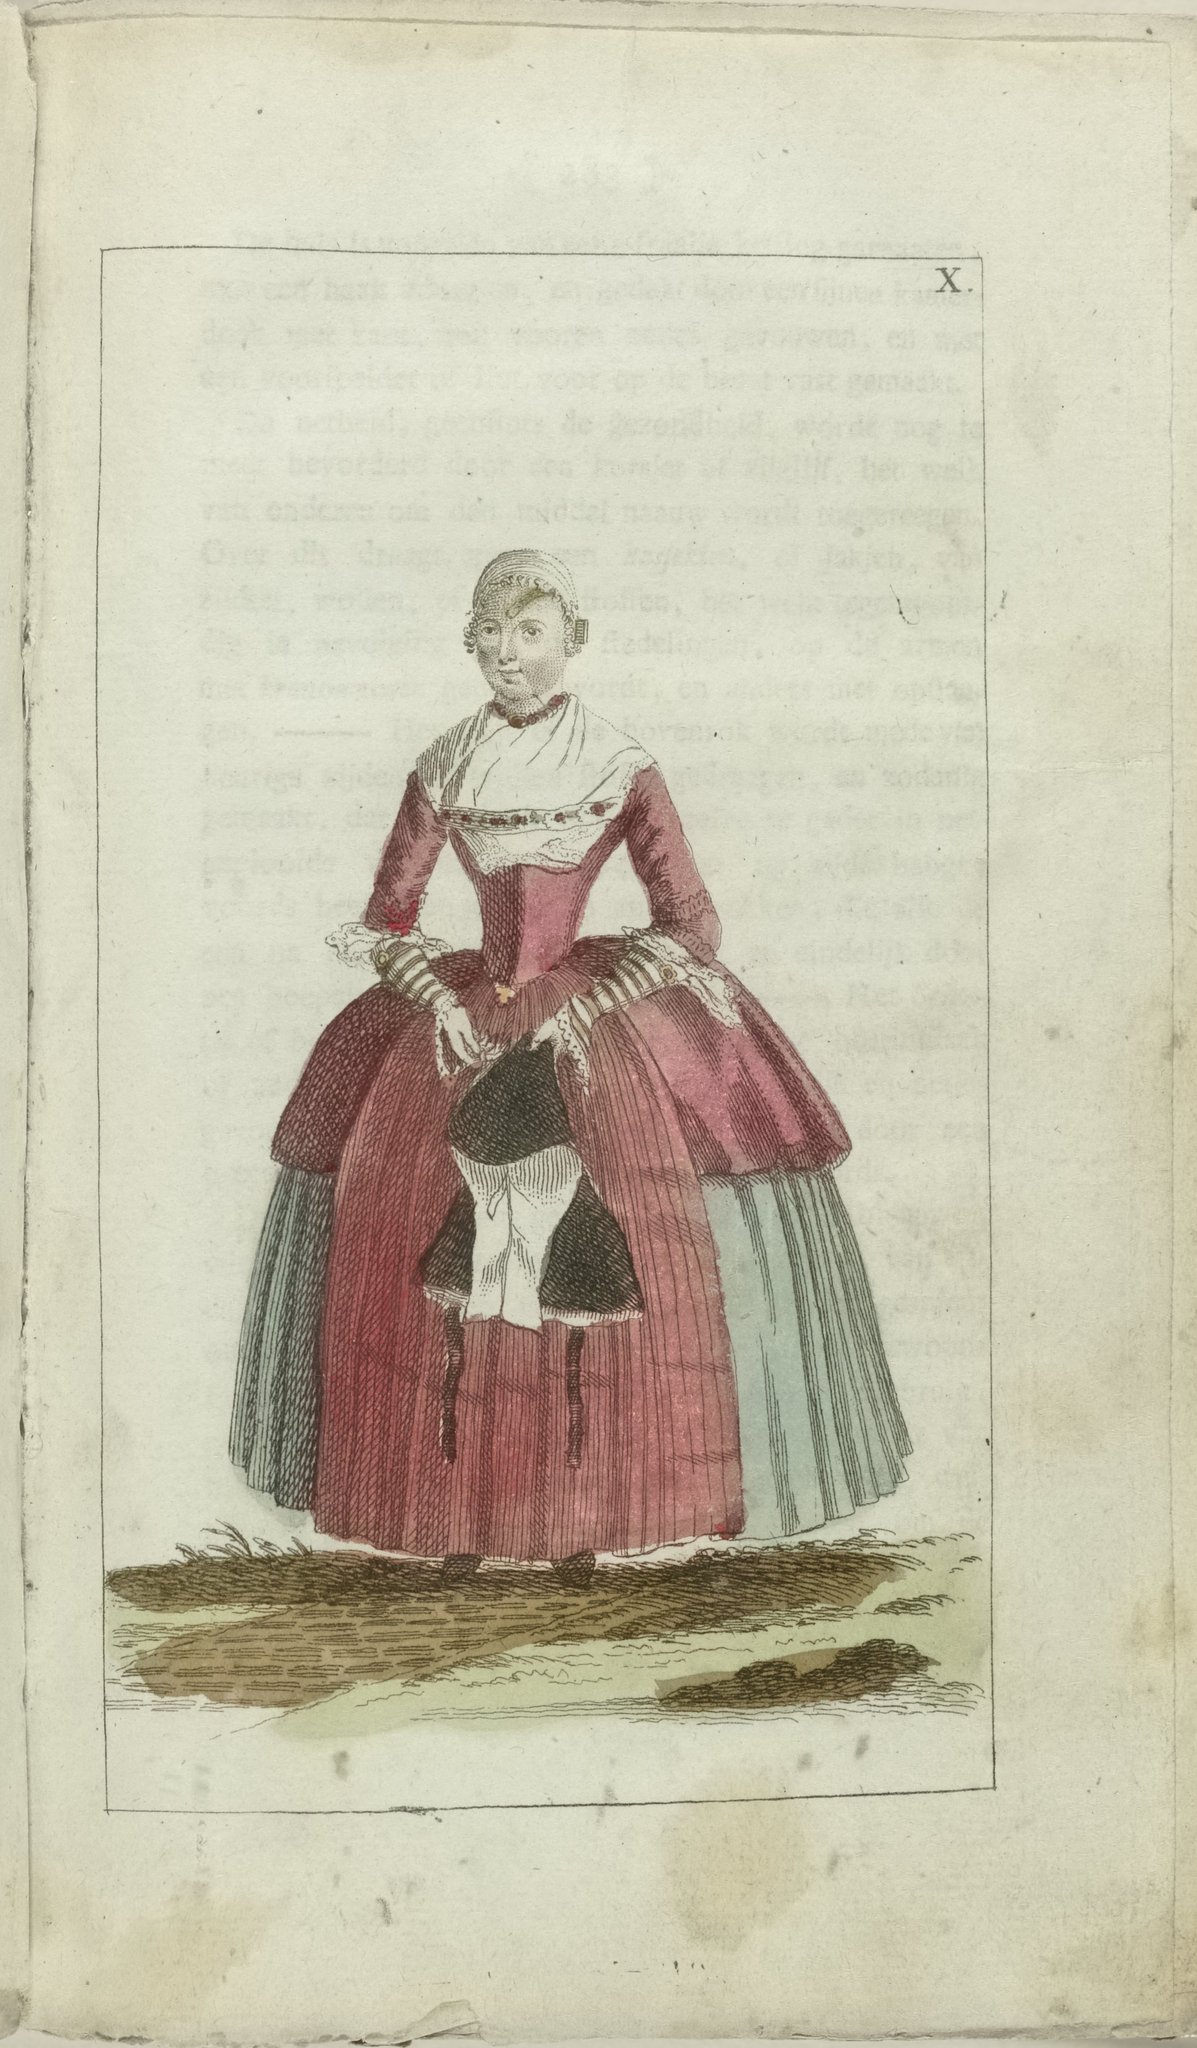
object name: fashion print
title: Kabinet van mode en smaak 1791, pl. X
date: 1791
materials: paper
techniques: etching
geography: haarlem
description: Uit "Vaderlandsche Dragten": Vrouw uit Zaandam... p. 282